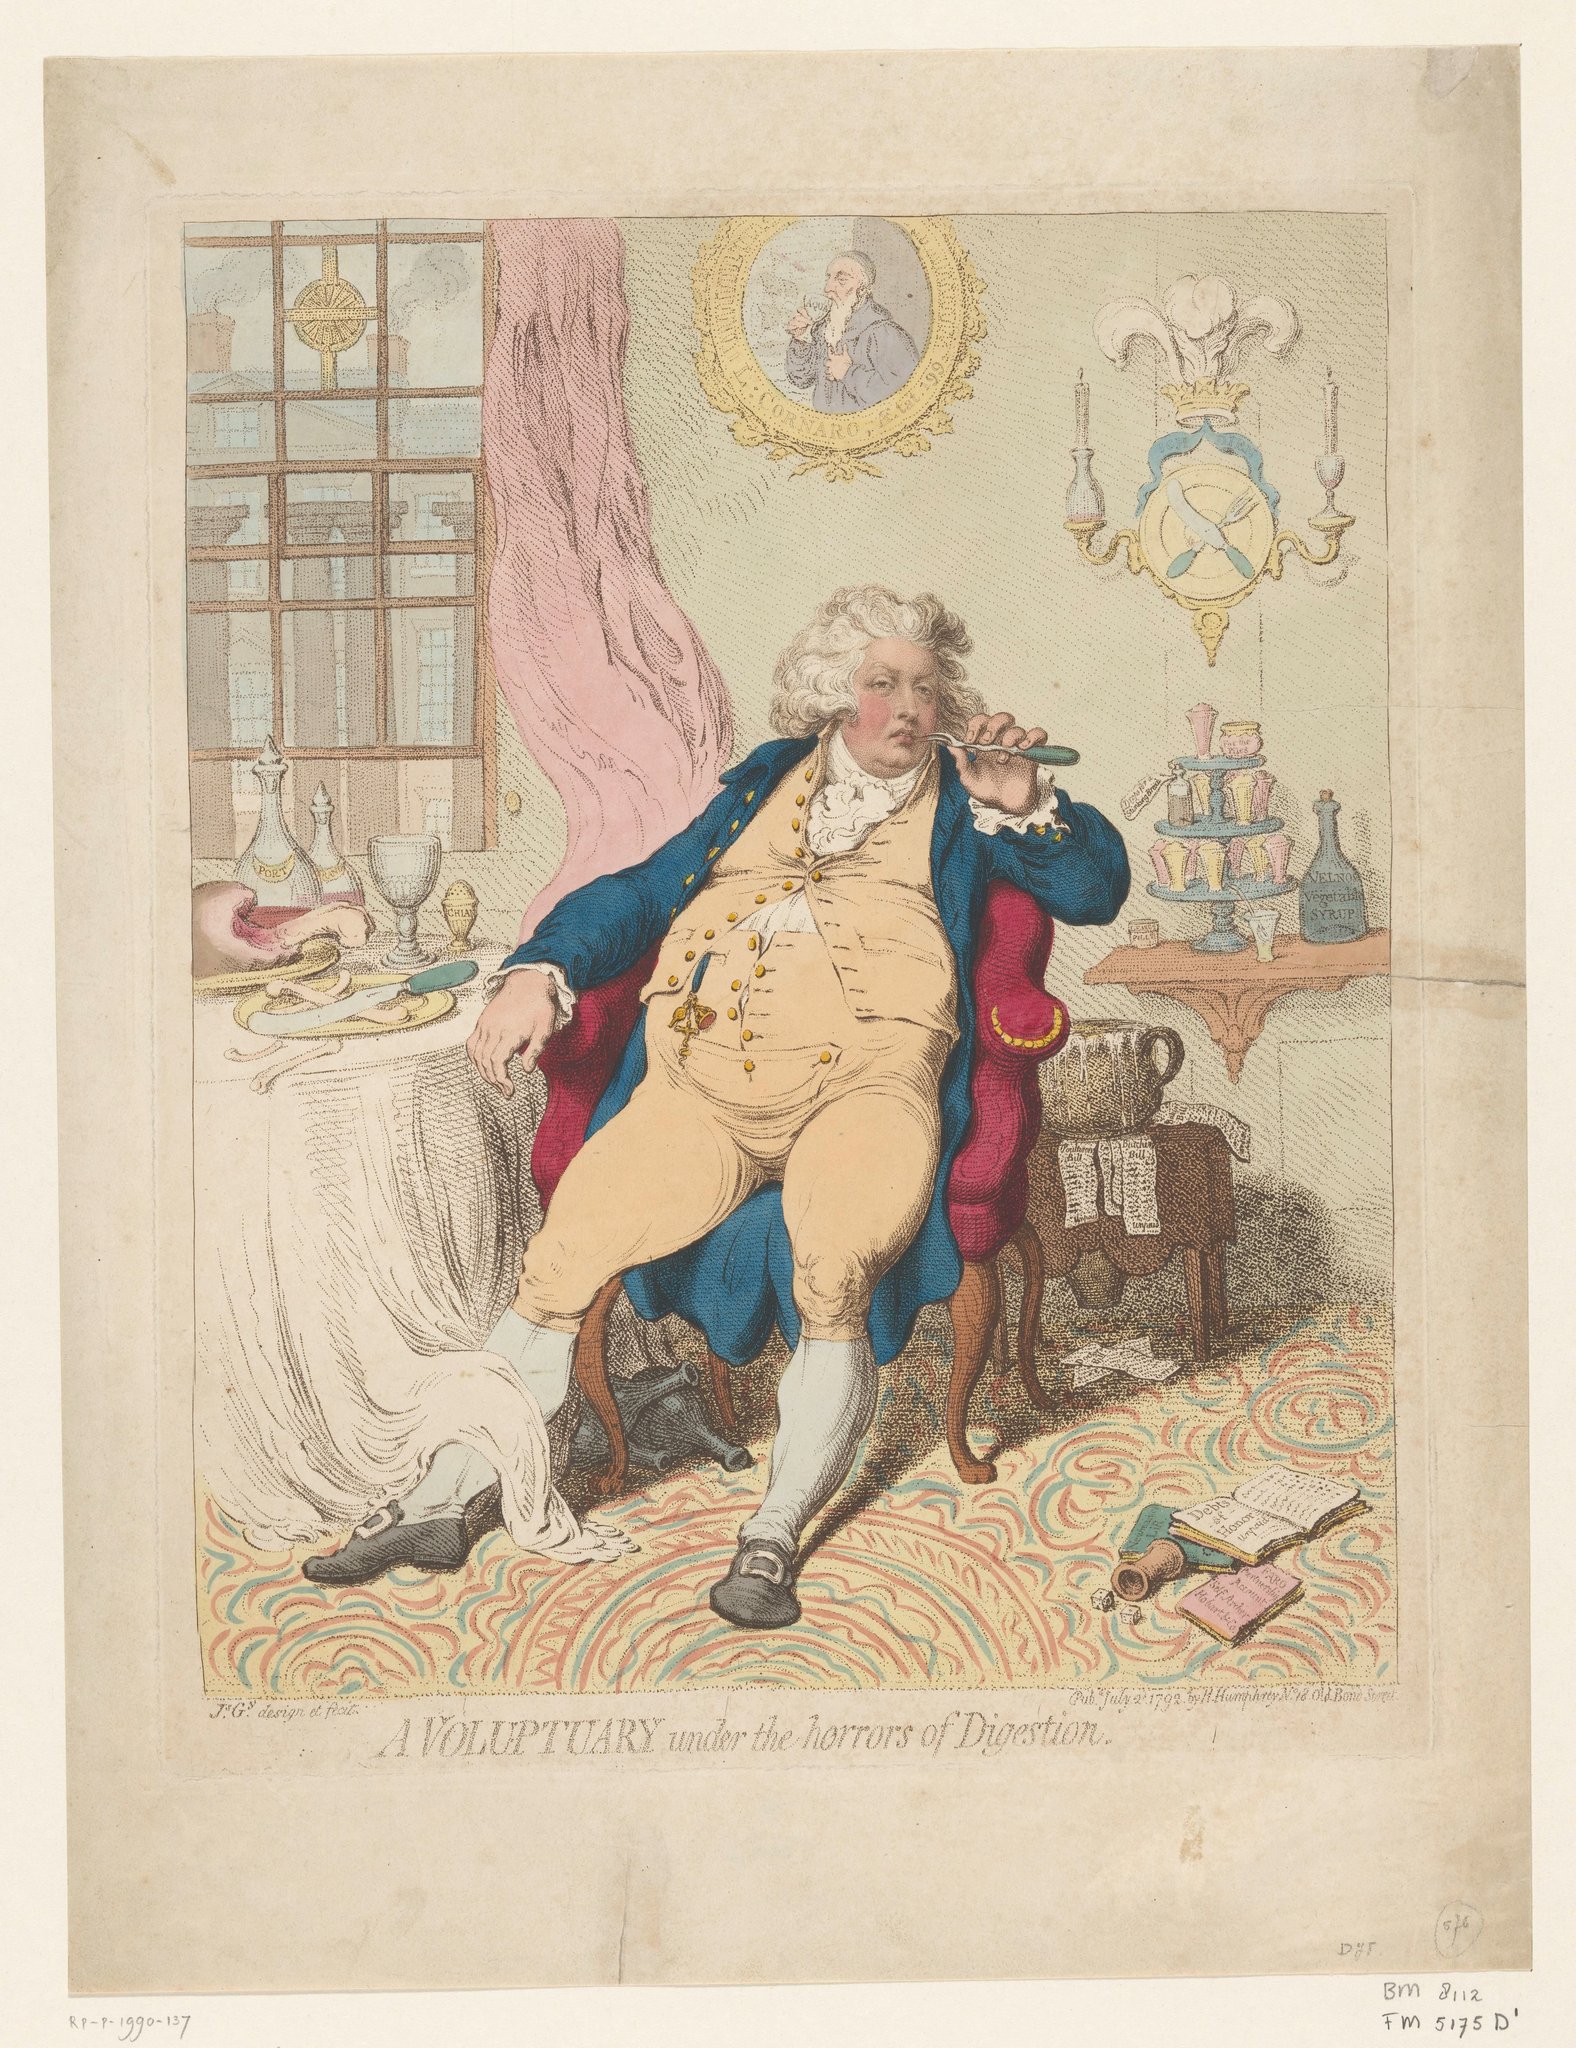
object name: cartoon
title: Spotprent op George IV, 1792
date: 1792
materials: paper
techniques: etching, hand coloring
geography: london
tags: george iv (koning van het verenigd koninkrijk), fat (human type), toothpick, eating and drinking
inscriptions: collector's mark: Lugt 2228, collector's mark: Lugt 2760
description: Spotprent op de Prince of Wales, de latere koning George IV, 1792. De prins maakt zijn tanden schoon met een vork, na een flinke maaltijd.